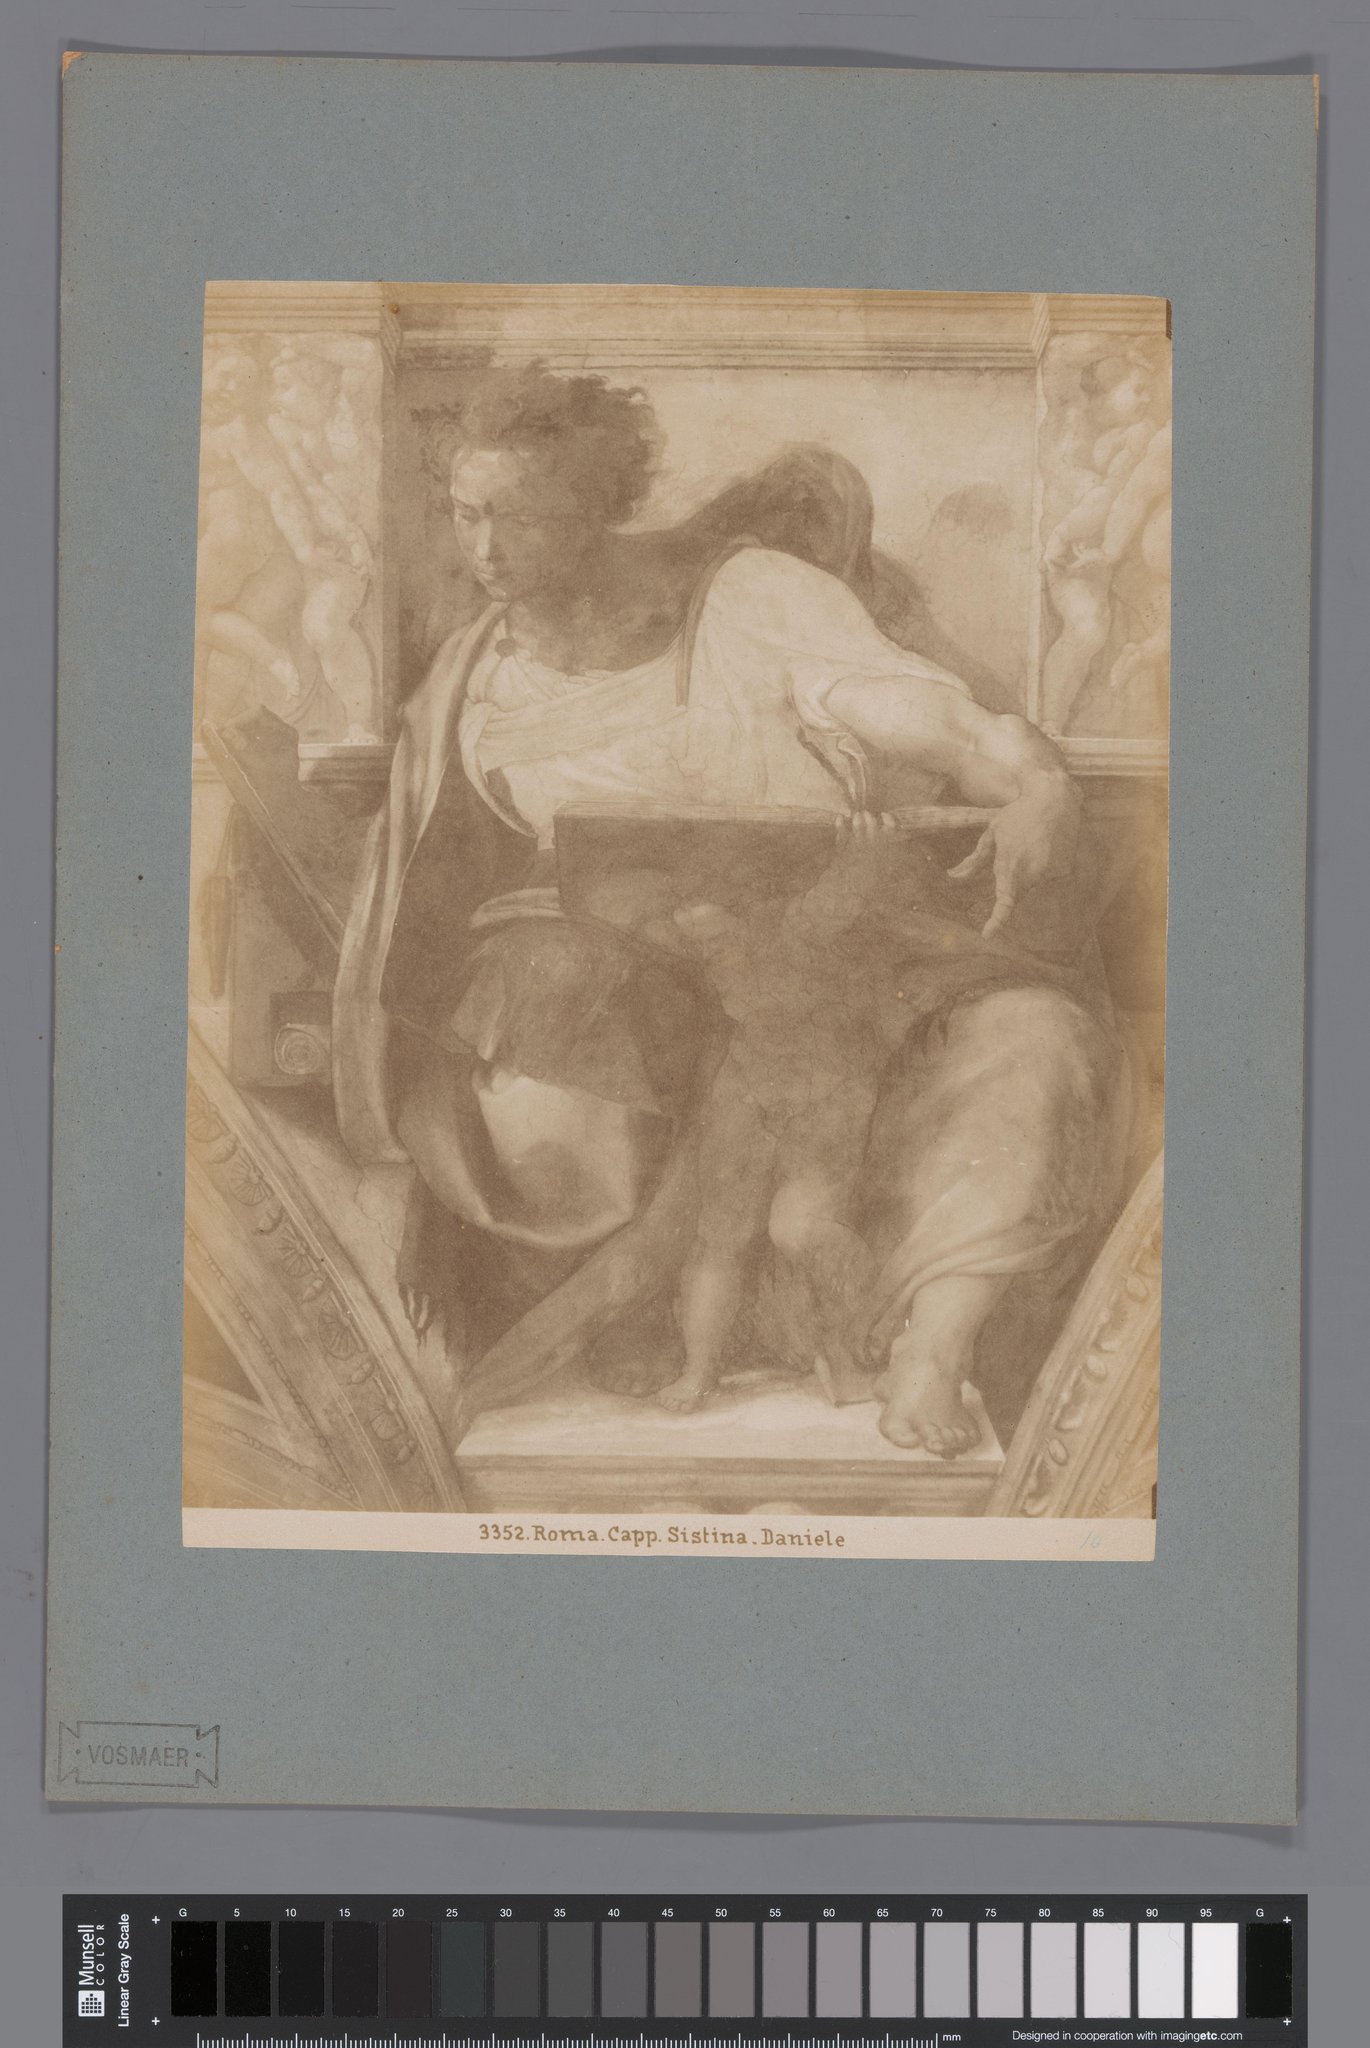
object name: reproduction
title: Roma. Capp. Sistina. Daniele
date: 1851-1900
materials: cardboard, paper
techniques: albumen print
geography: vatican city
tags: the story of the prophet daniel; his visions and prophecies, picture, painting, wall-covering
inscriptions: collector's mark: ‘VOSMAER’, number: ‘3352.’